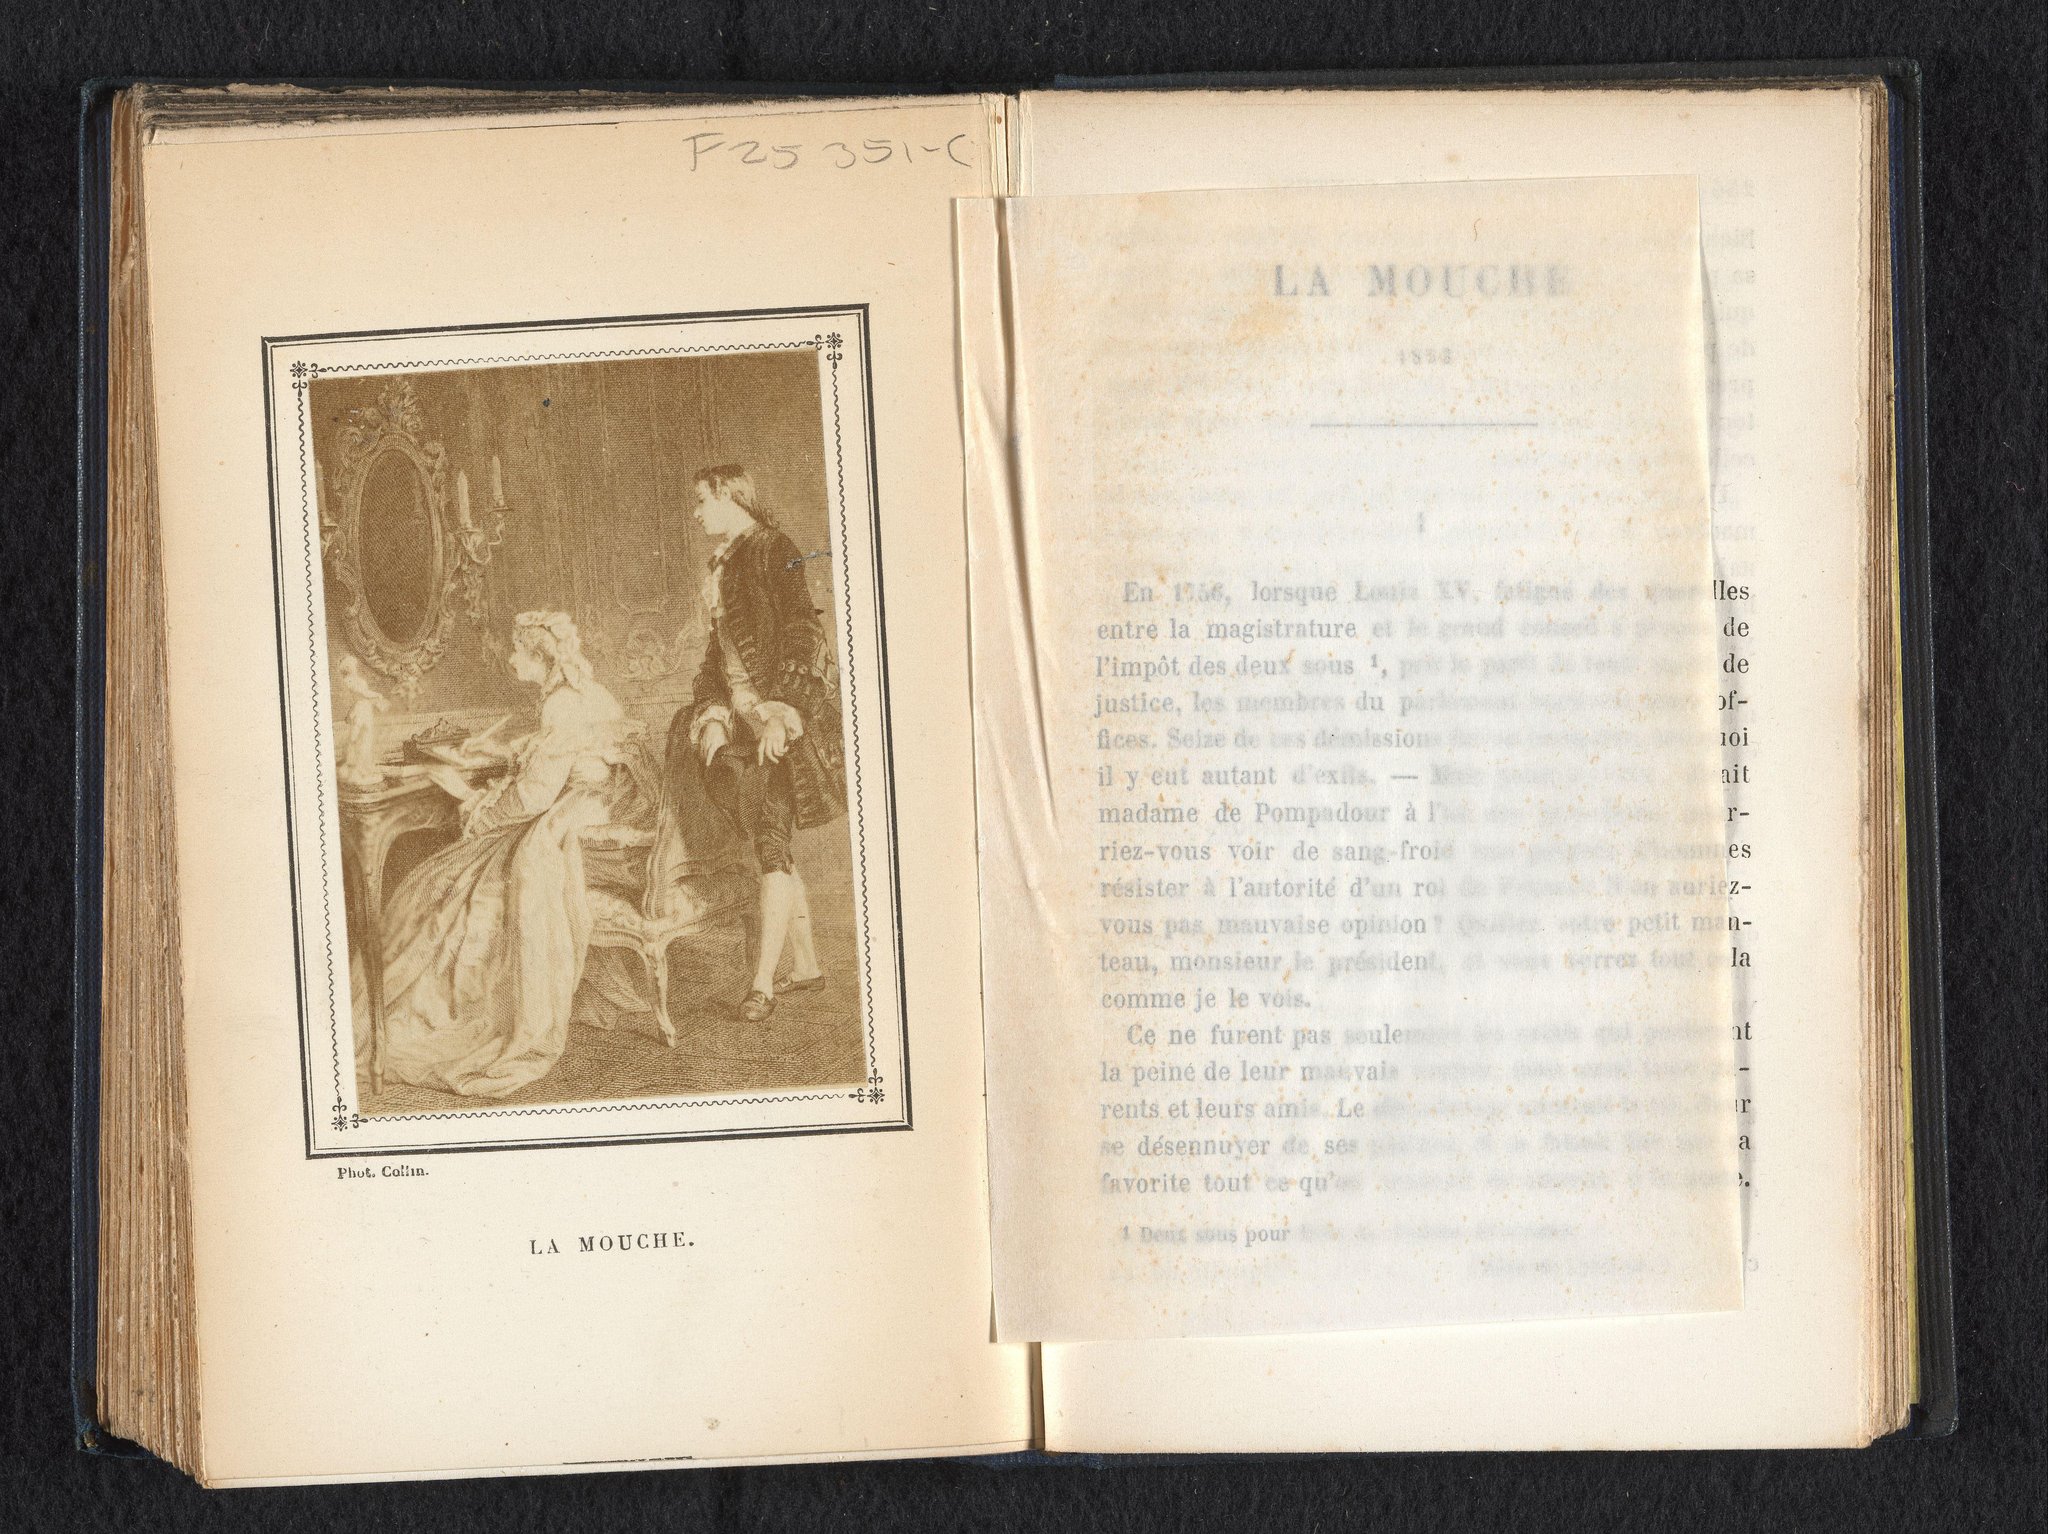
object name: reproduction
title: Fotoreproductie van de gravure La mouche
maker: collin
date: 1862-1867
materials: paper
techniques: albumen print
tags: print, e.g.: engraving, etching, lithograph